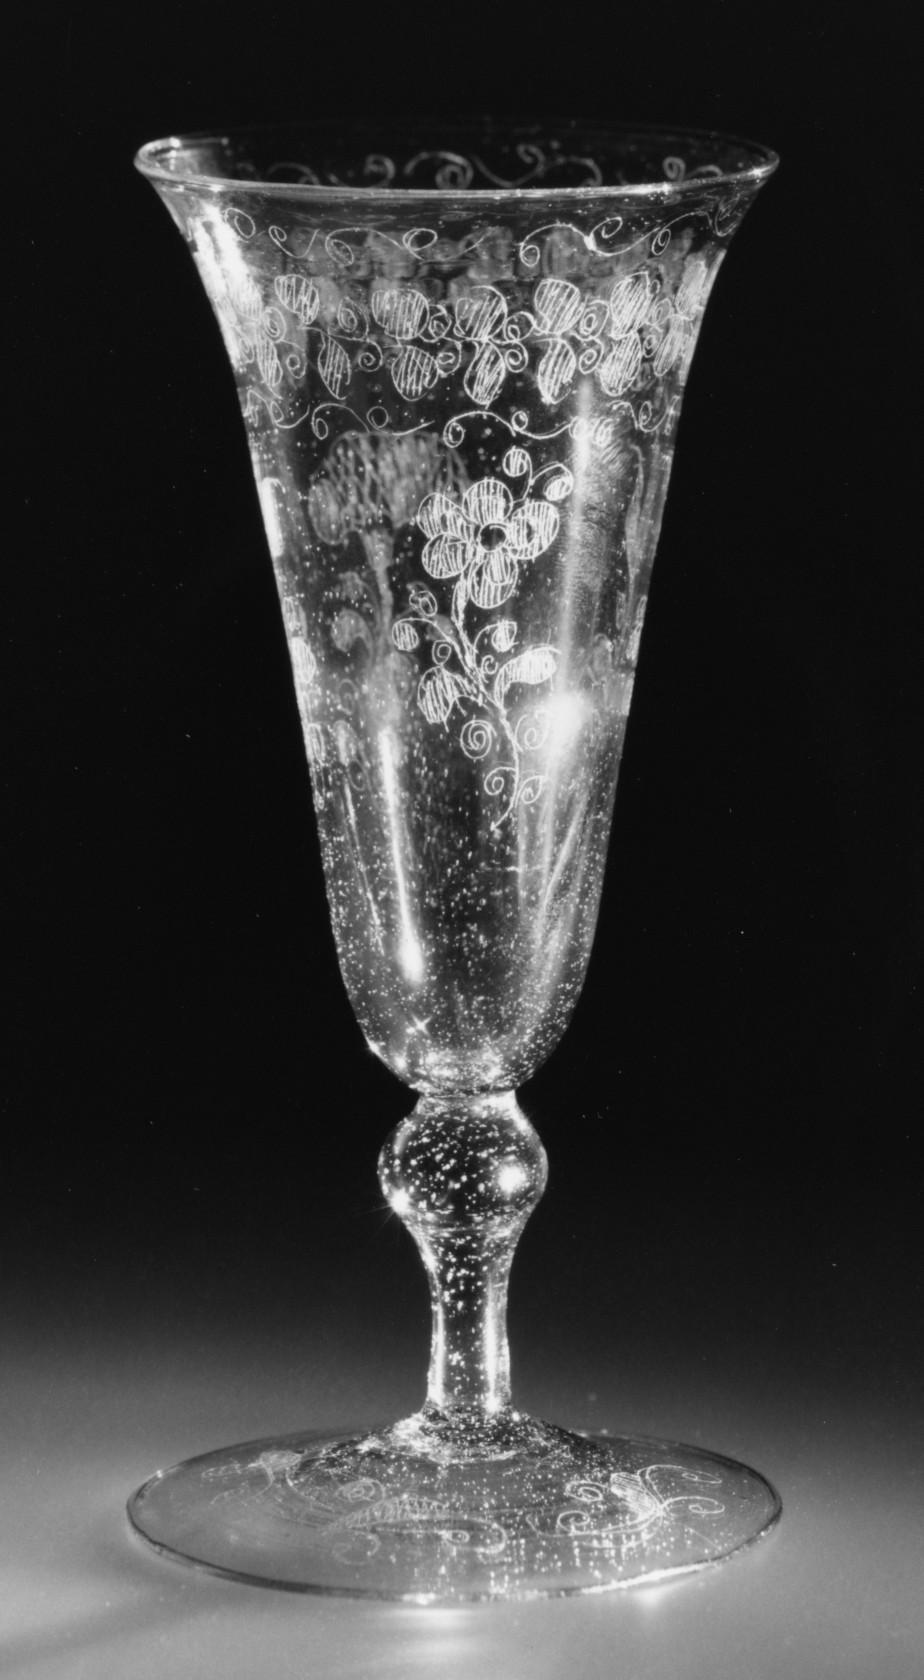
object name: wineglass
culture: façon de venise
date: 1601-1633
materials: diamond, glass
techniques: glassblowing, engraving